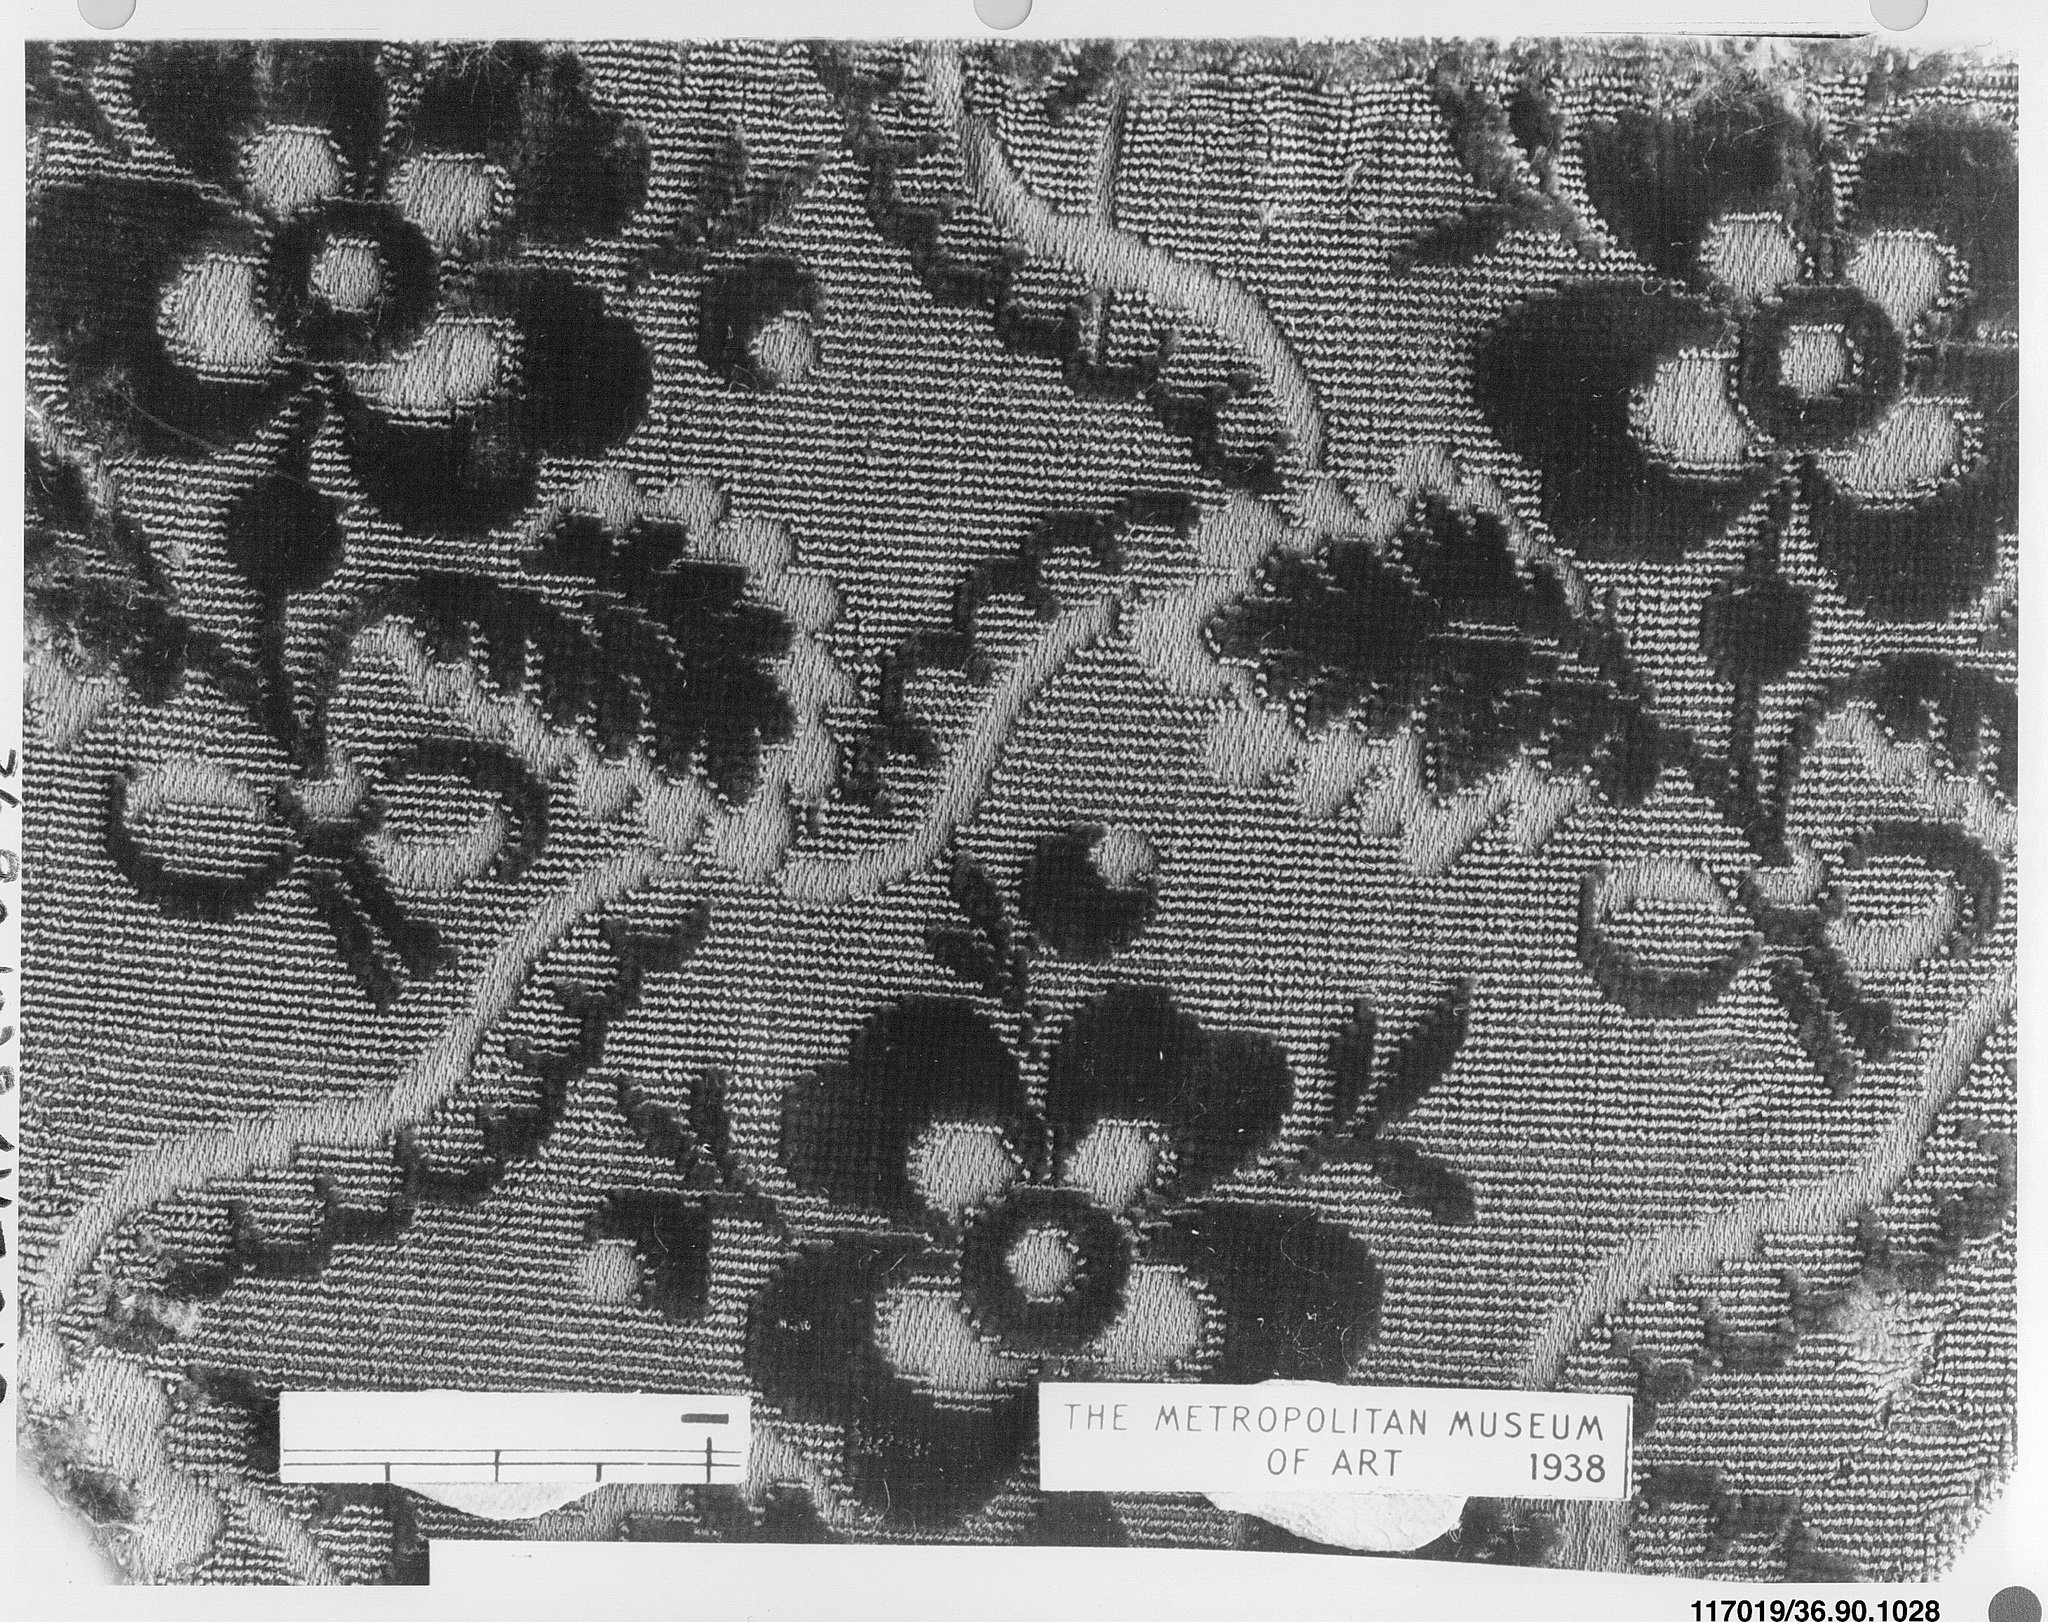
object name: piece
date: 1701-1800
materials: silk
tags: flowers,leaves